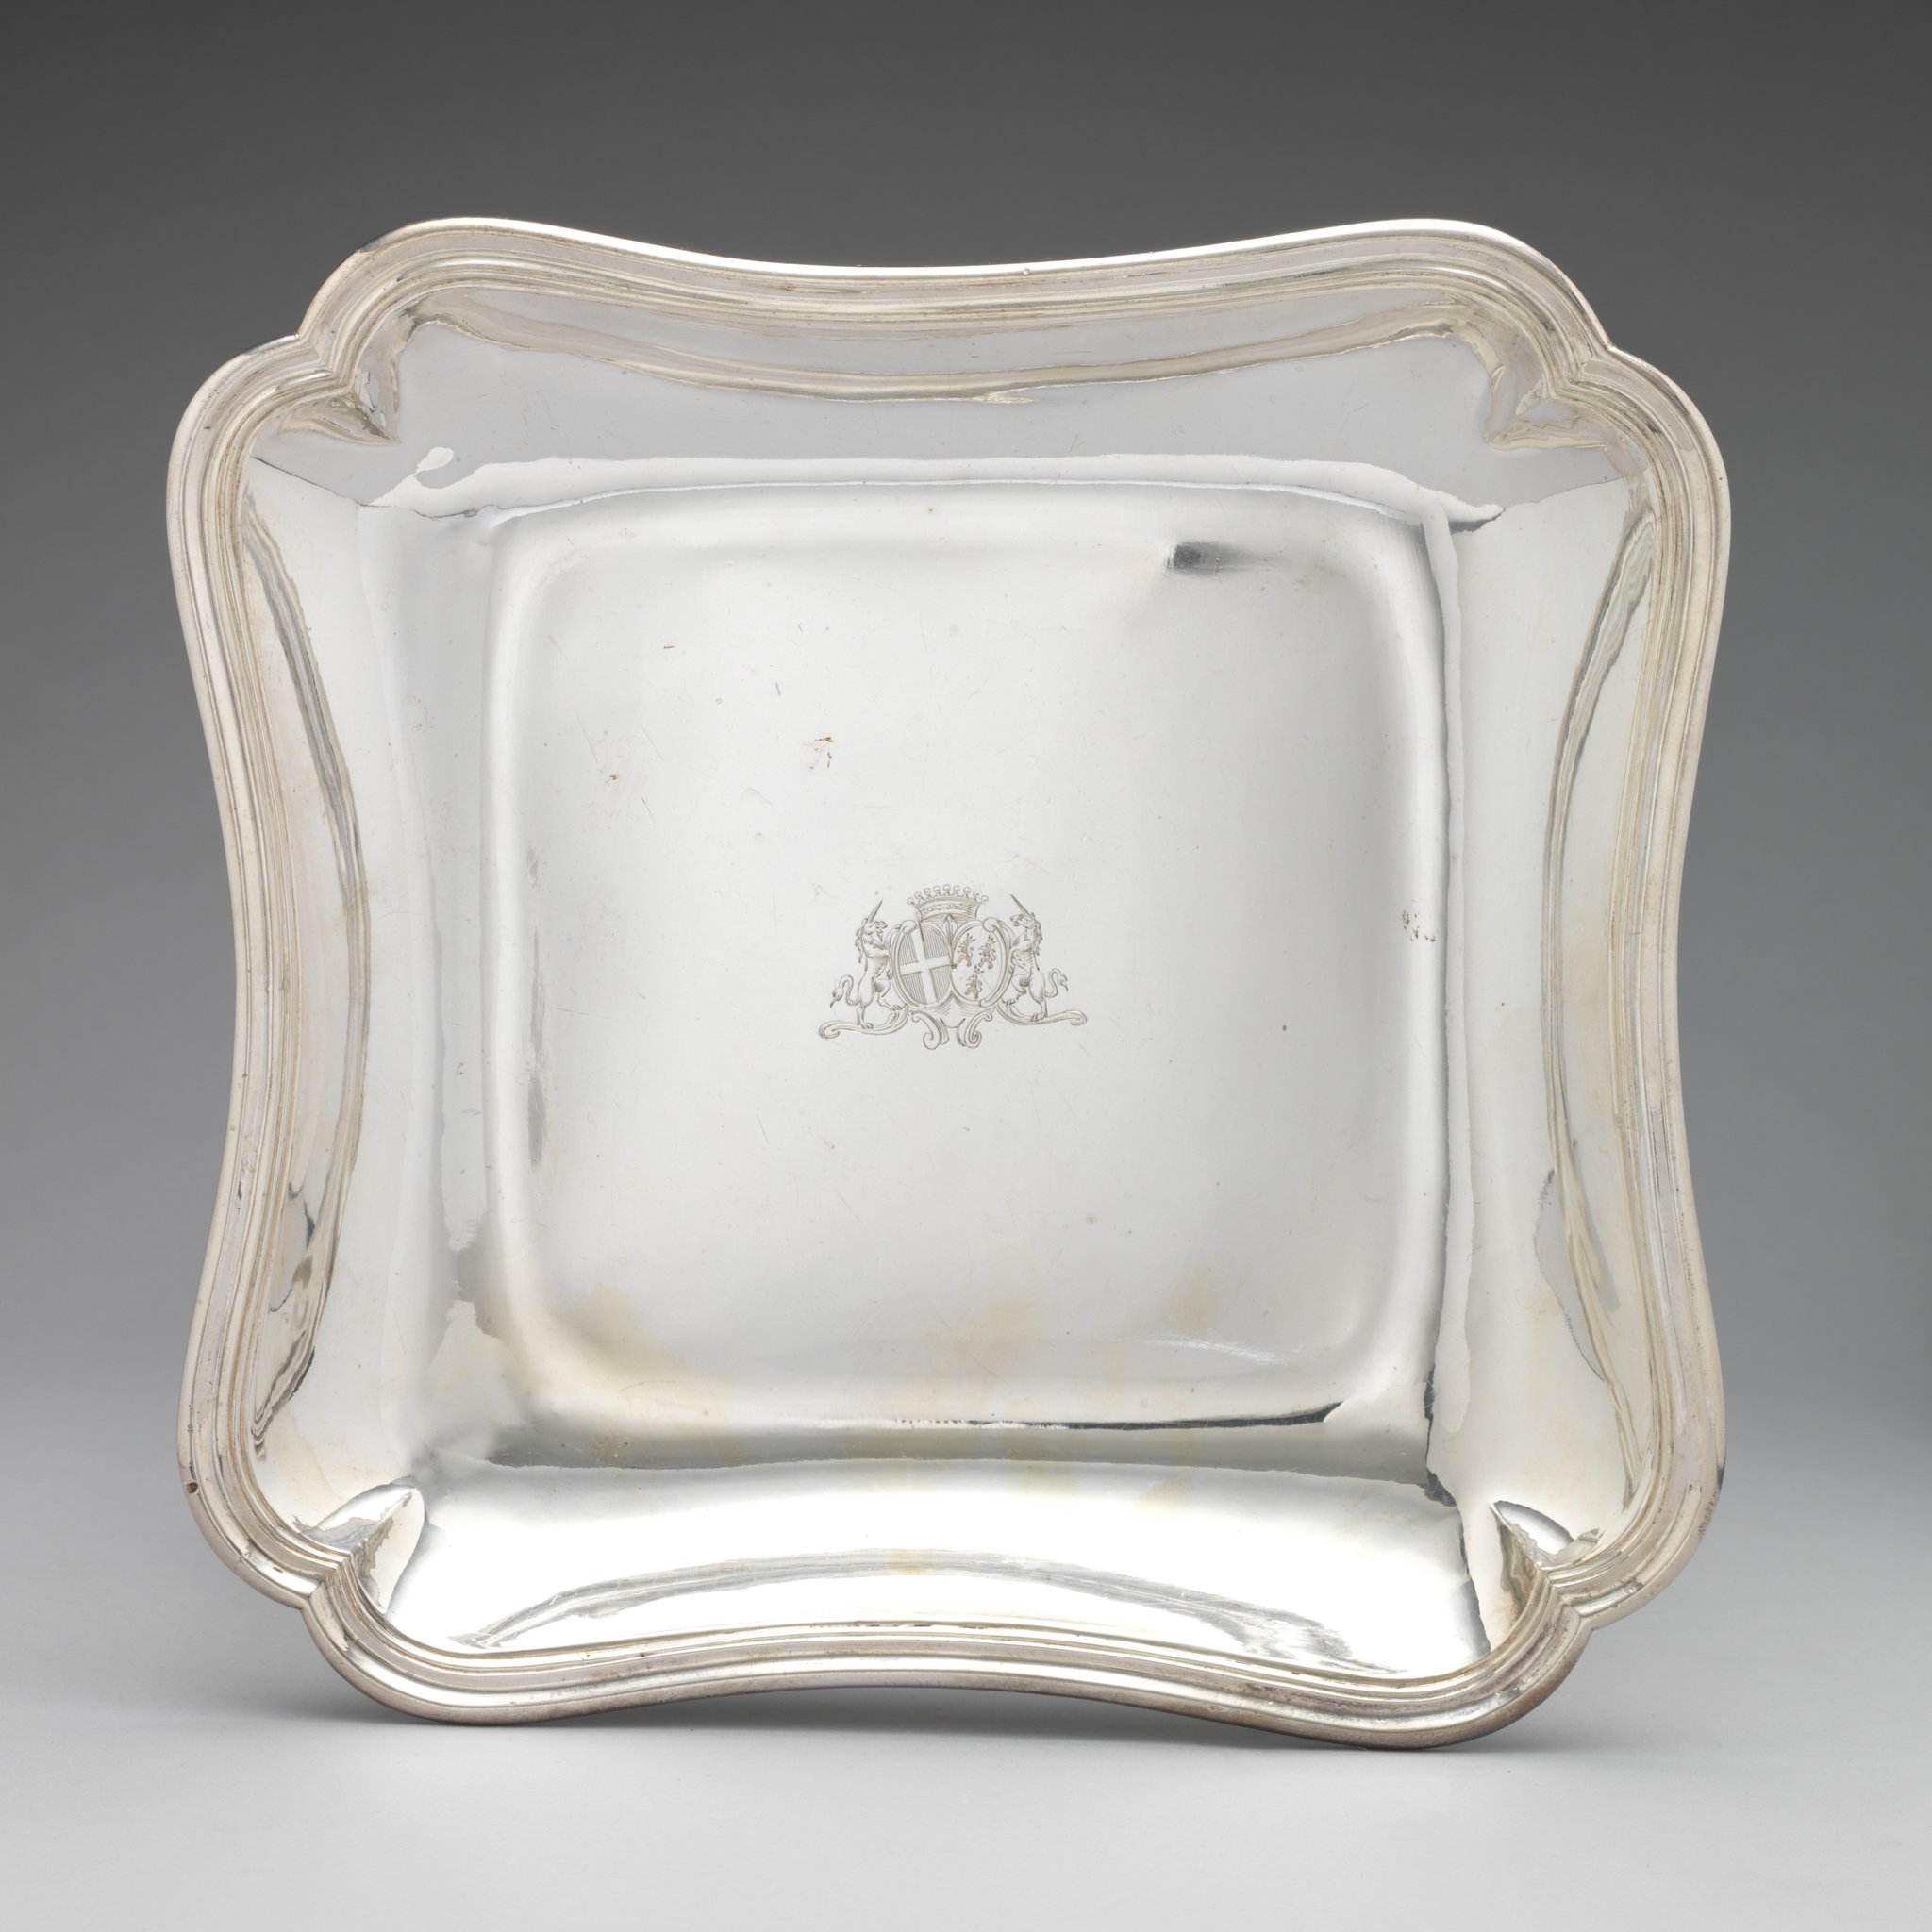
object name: dish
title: Square dish (one of a pair)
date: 1775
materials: silver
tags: coat of arms